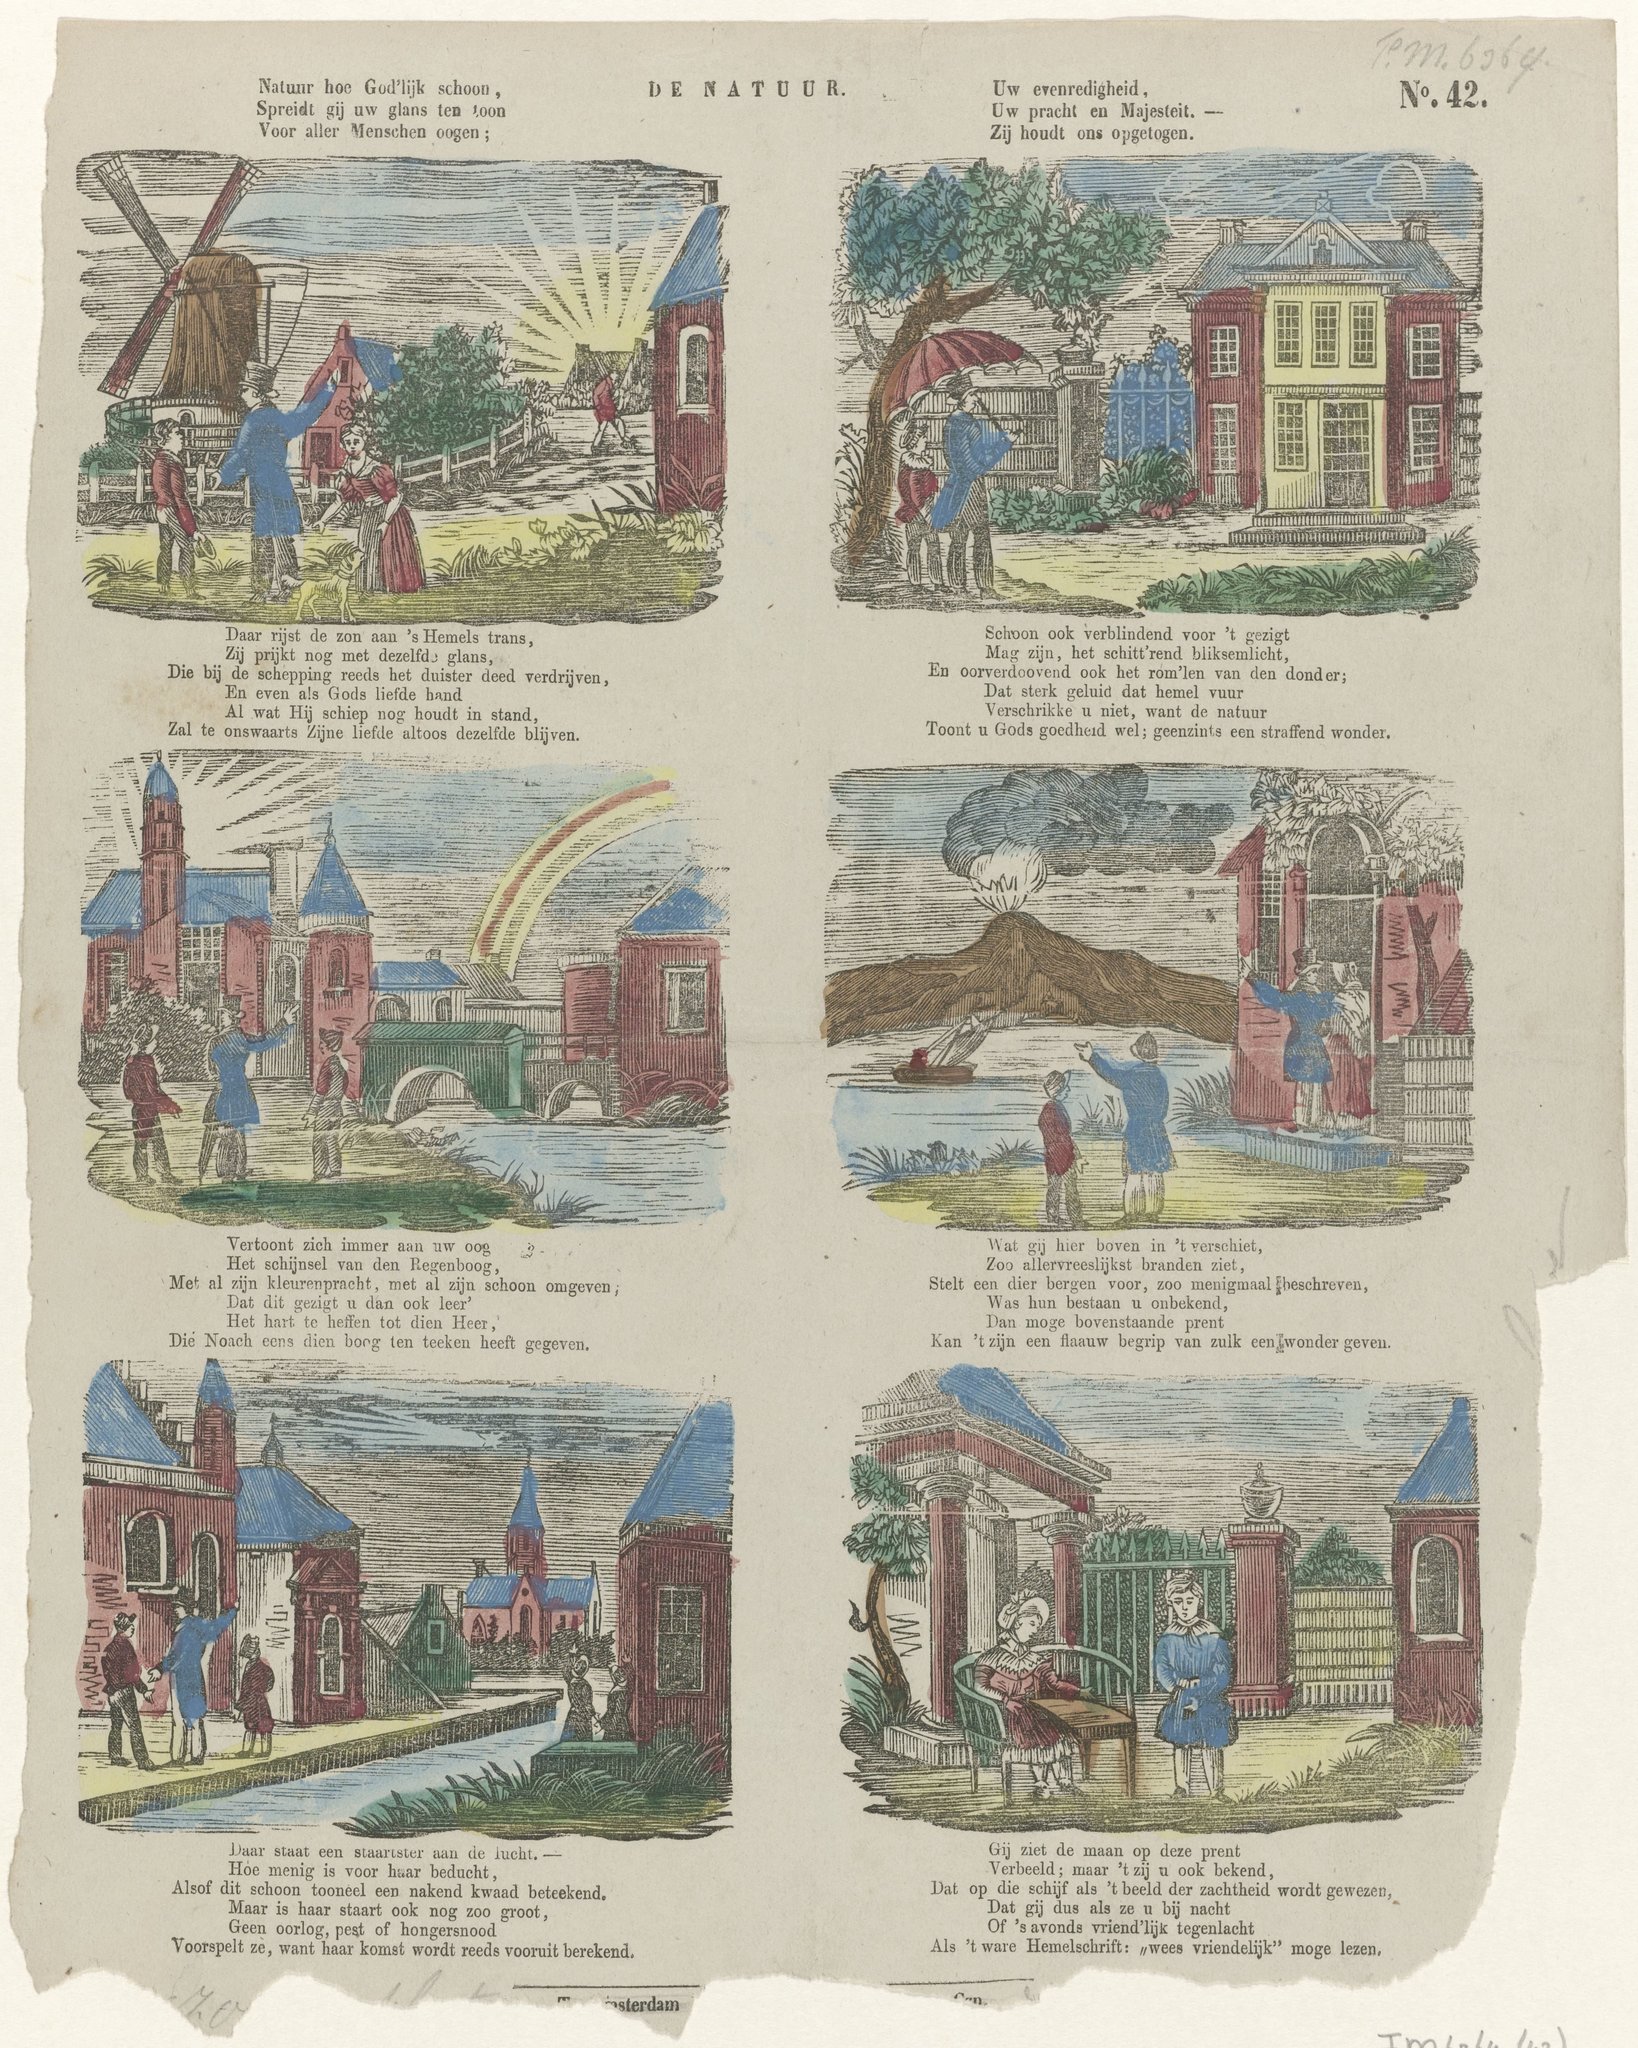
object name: popular print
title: De Natuur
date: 1850-1870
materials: paper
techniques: colour, letterpress printing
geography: amsterdam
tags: meteorological phenomena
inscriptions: collector's mark: Lugt 2228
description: Blad met zes voorstellingen over de natuur en natuurverschijnselen. Onder elk plaatje een zesregelig vers. Genummerd rechtsboven: No. 42. Ca. 1800-1850.